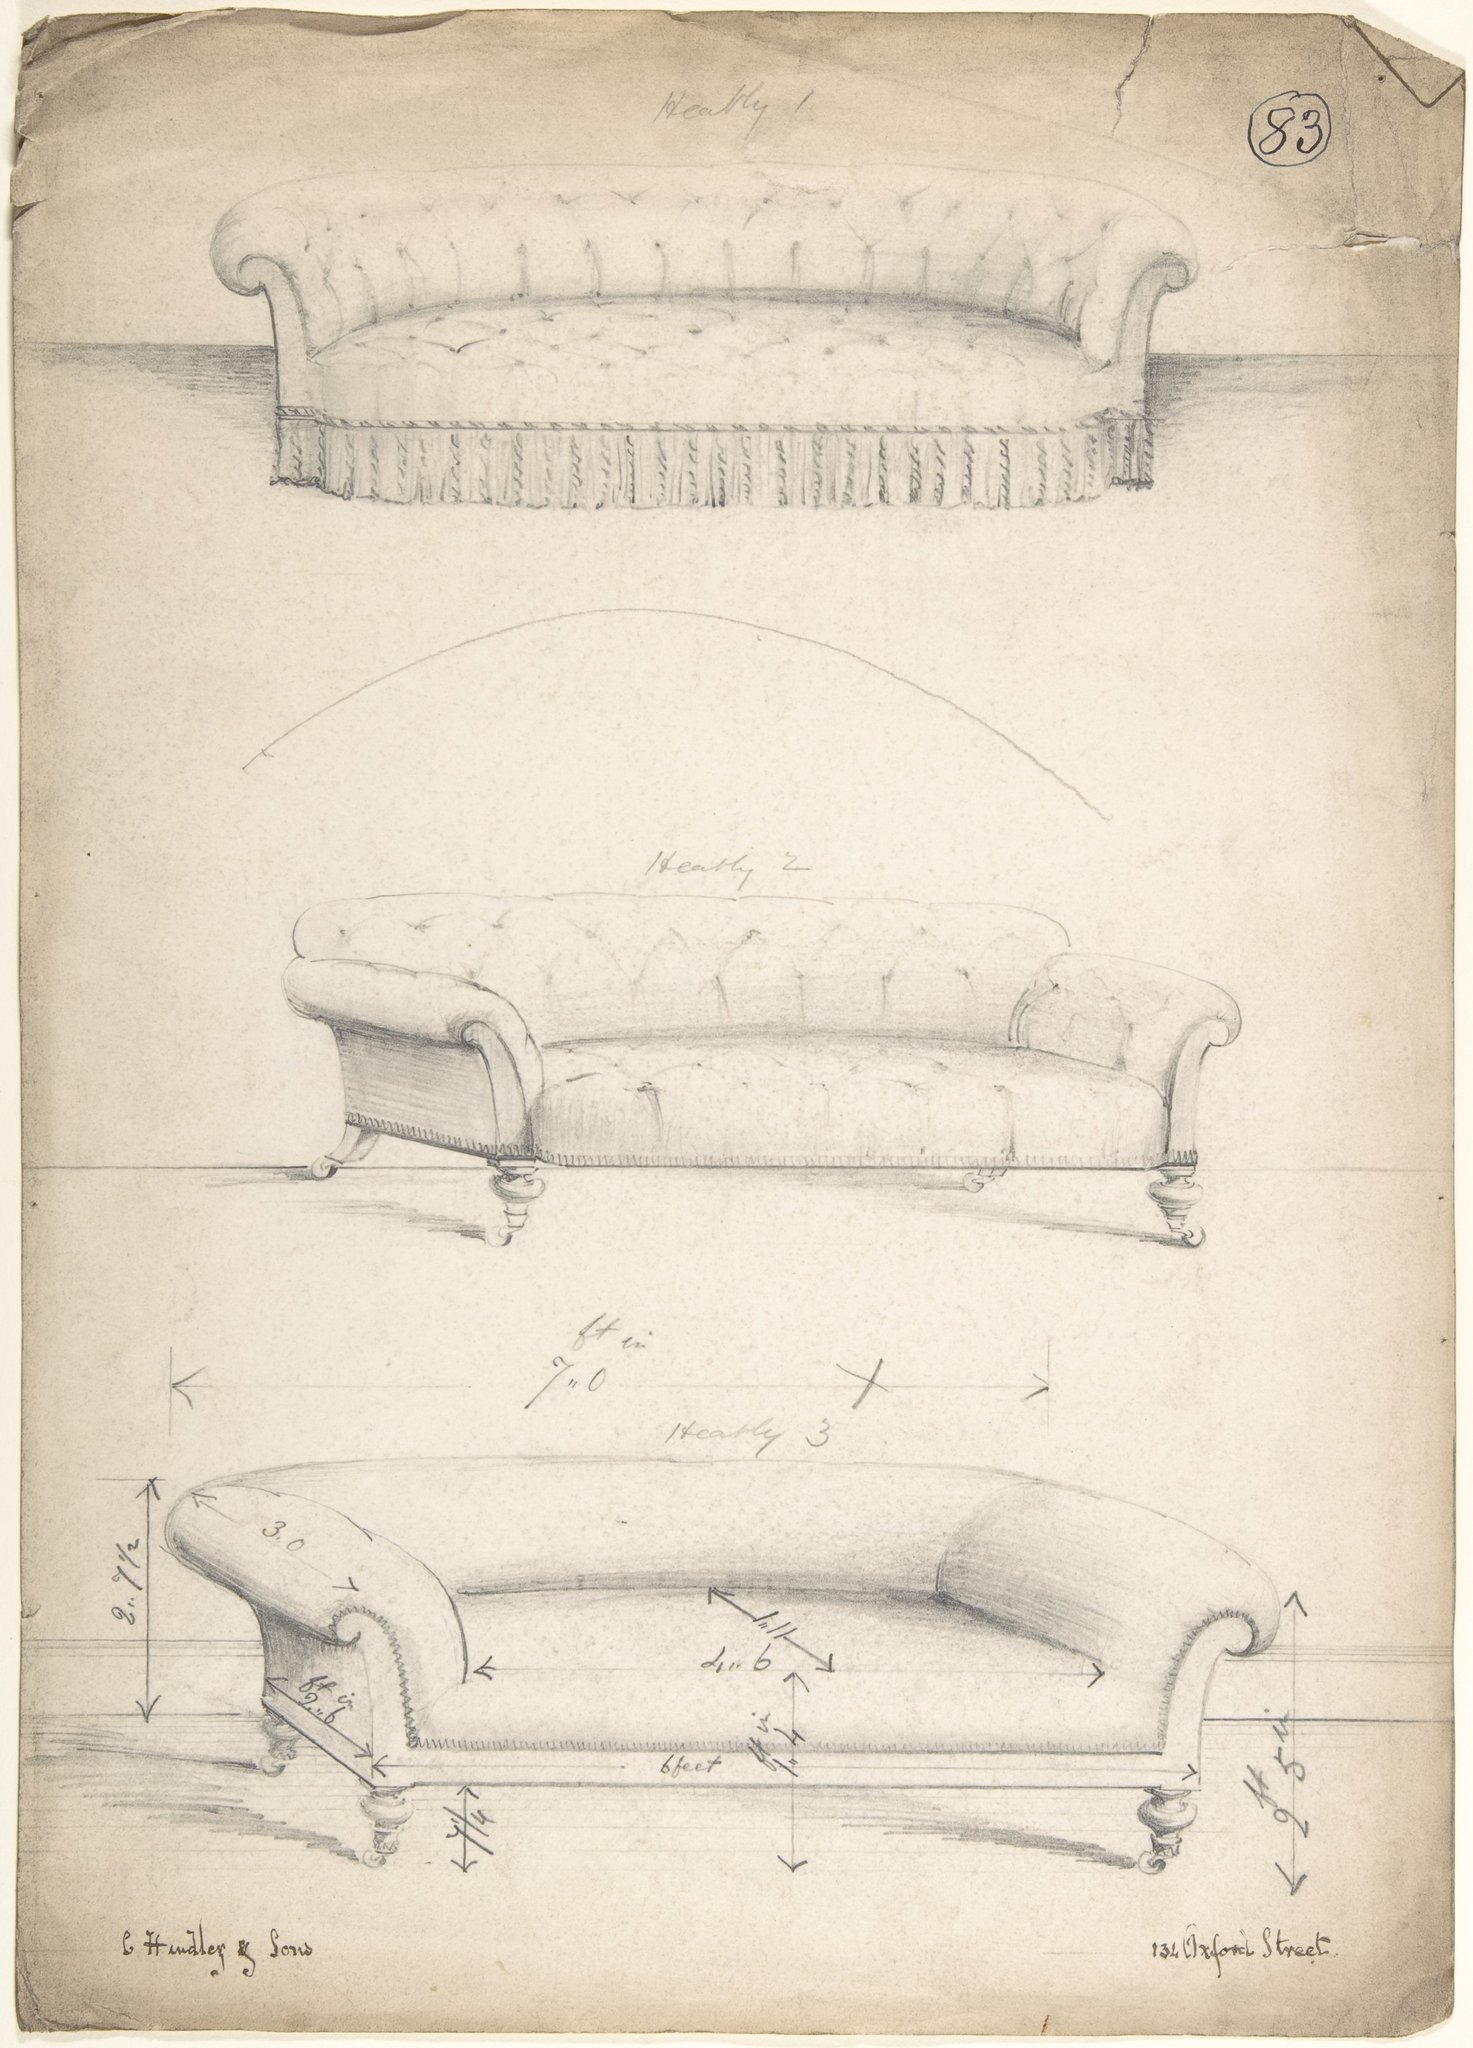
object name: drawing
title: Designs for Three Couches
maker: charles hindley and sons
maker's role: artist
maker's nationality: british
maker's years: 1841-1917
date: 1841-1884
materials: graphite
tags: couches